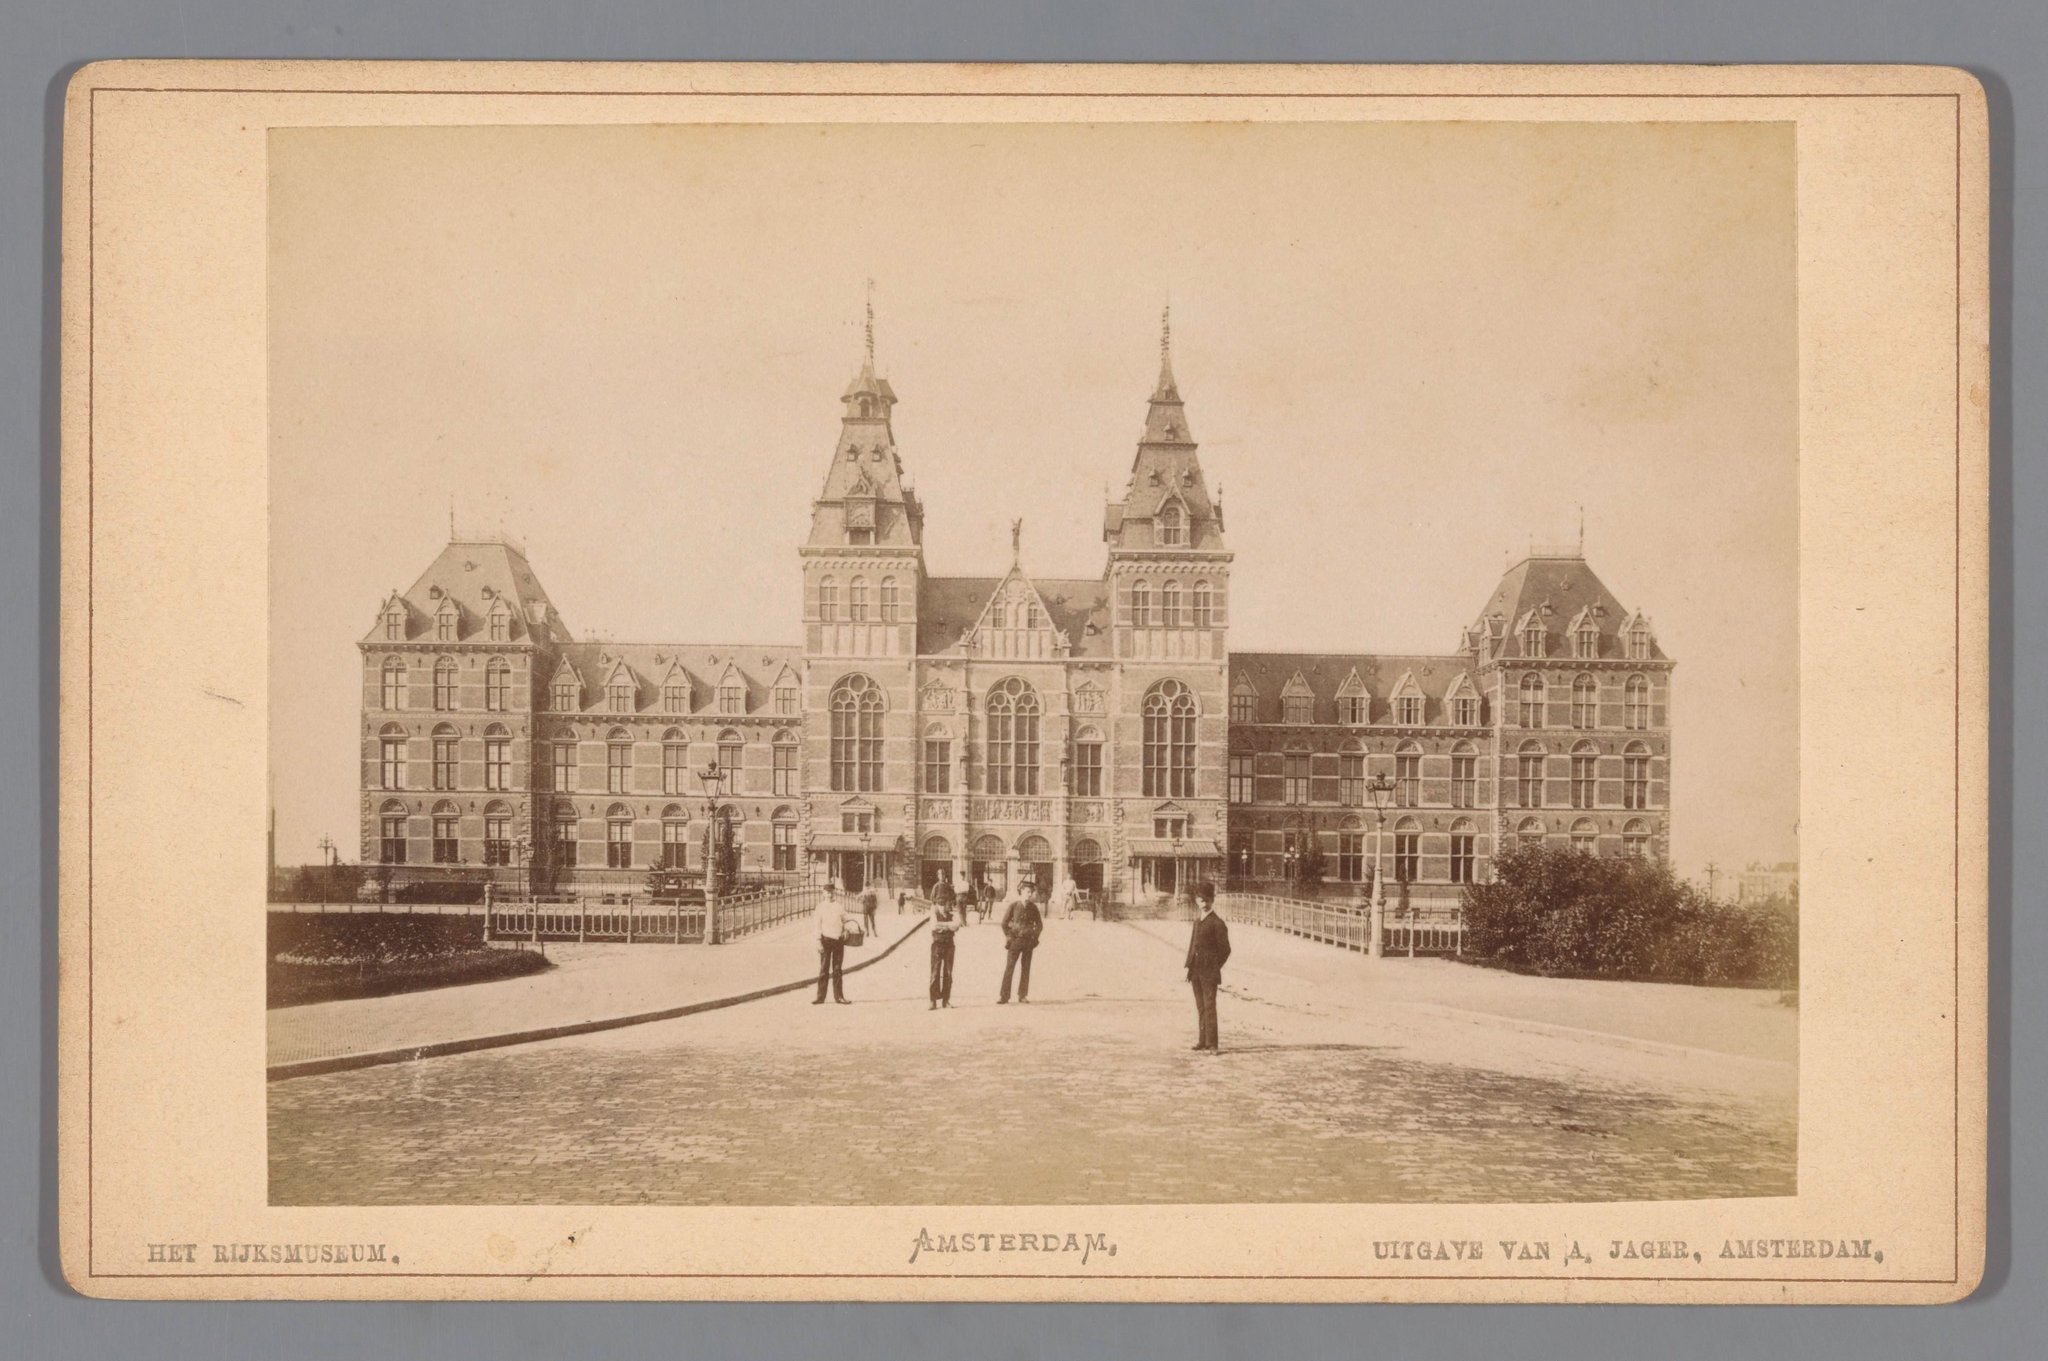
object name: photograph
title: Gezicht op het Rijksmuseum in Amsterdam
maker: andries jager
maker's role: publisher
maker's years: 1825-1905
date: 1885-1890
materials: cardboard, photographic support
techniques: albumen print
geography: amsterdam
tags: permanent exhibition, museum